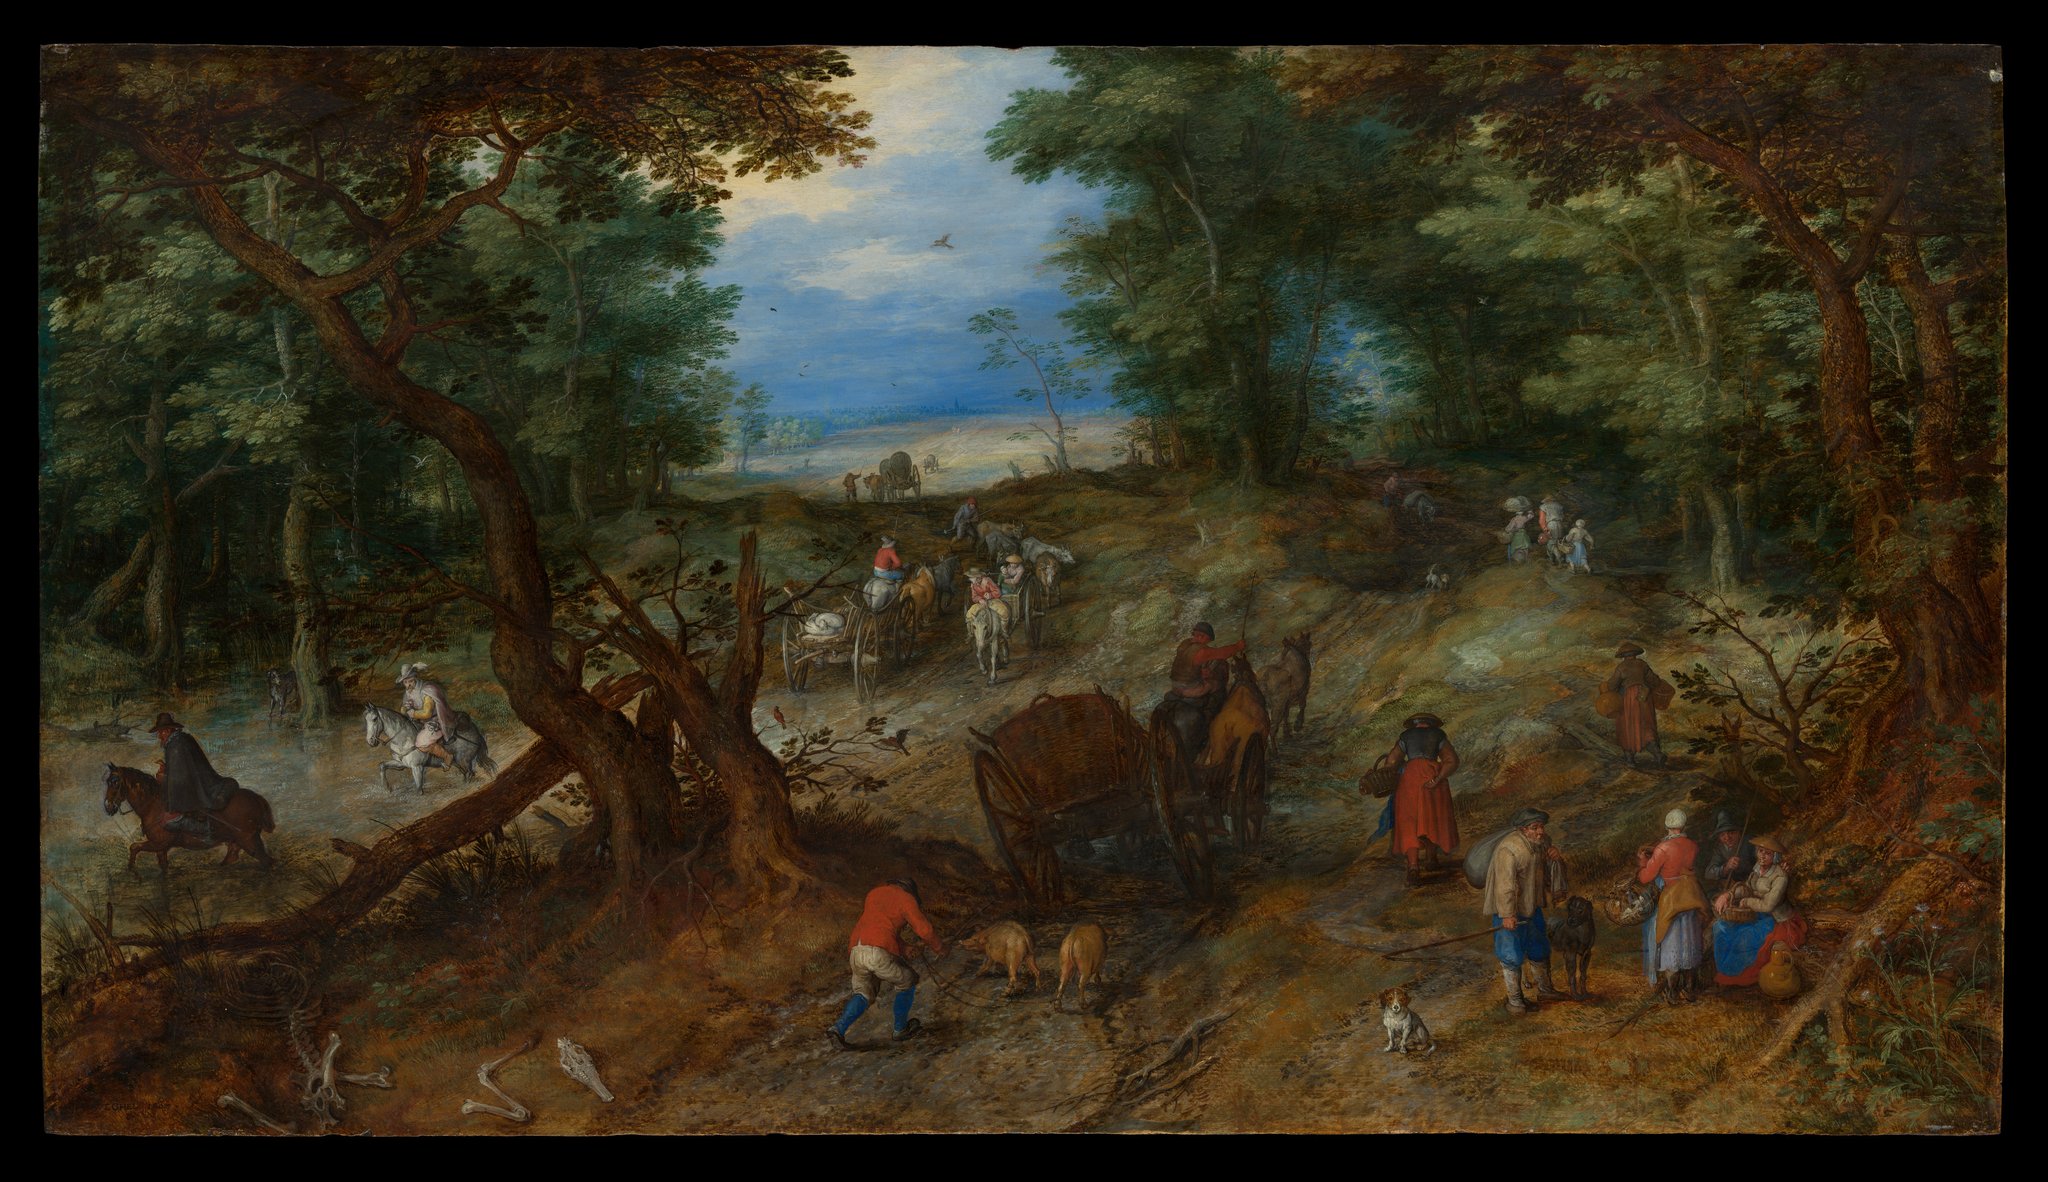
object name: painting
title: A Woodland Road with Travelers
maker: jan brueghel the elder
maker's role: artist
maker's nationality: netherlandish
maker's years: 1568-1625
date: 1607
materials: oil, wood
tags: human figures,roads,dogs,forests,wagons